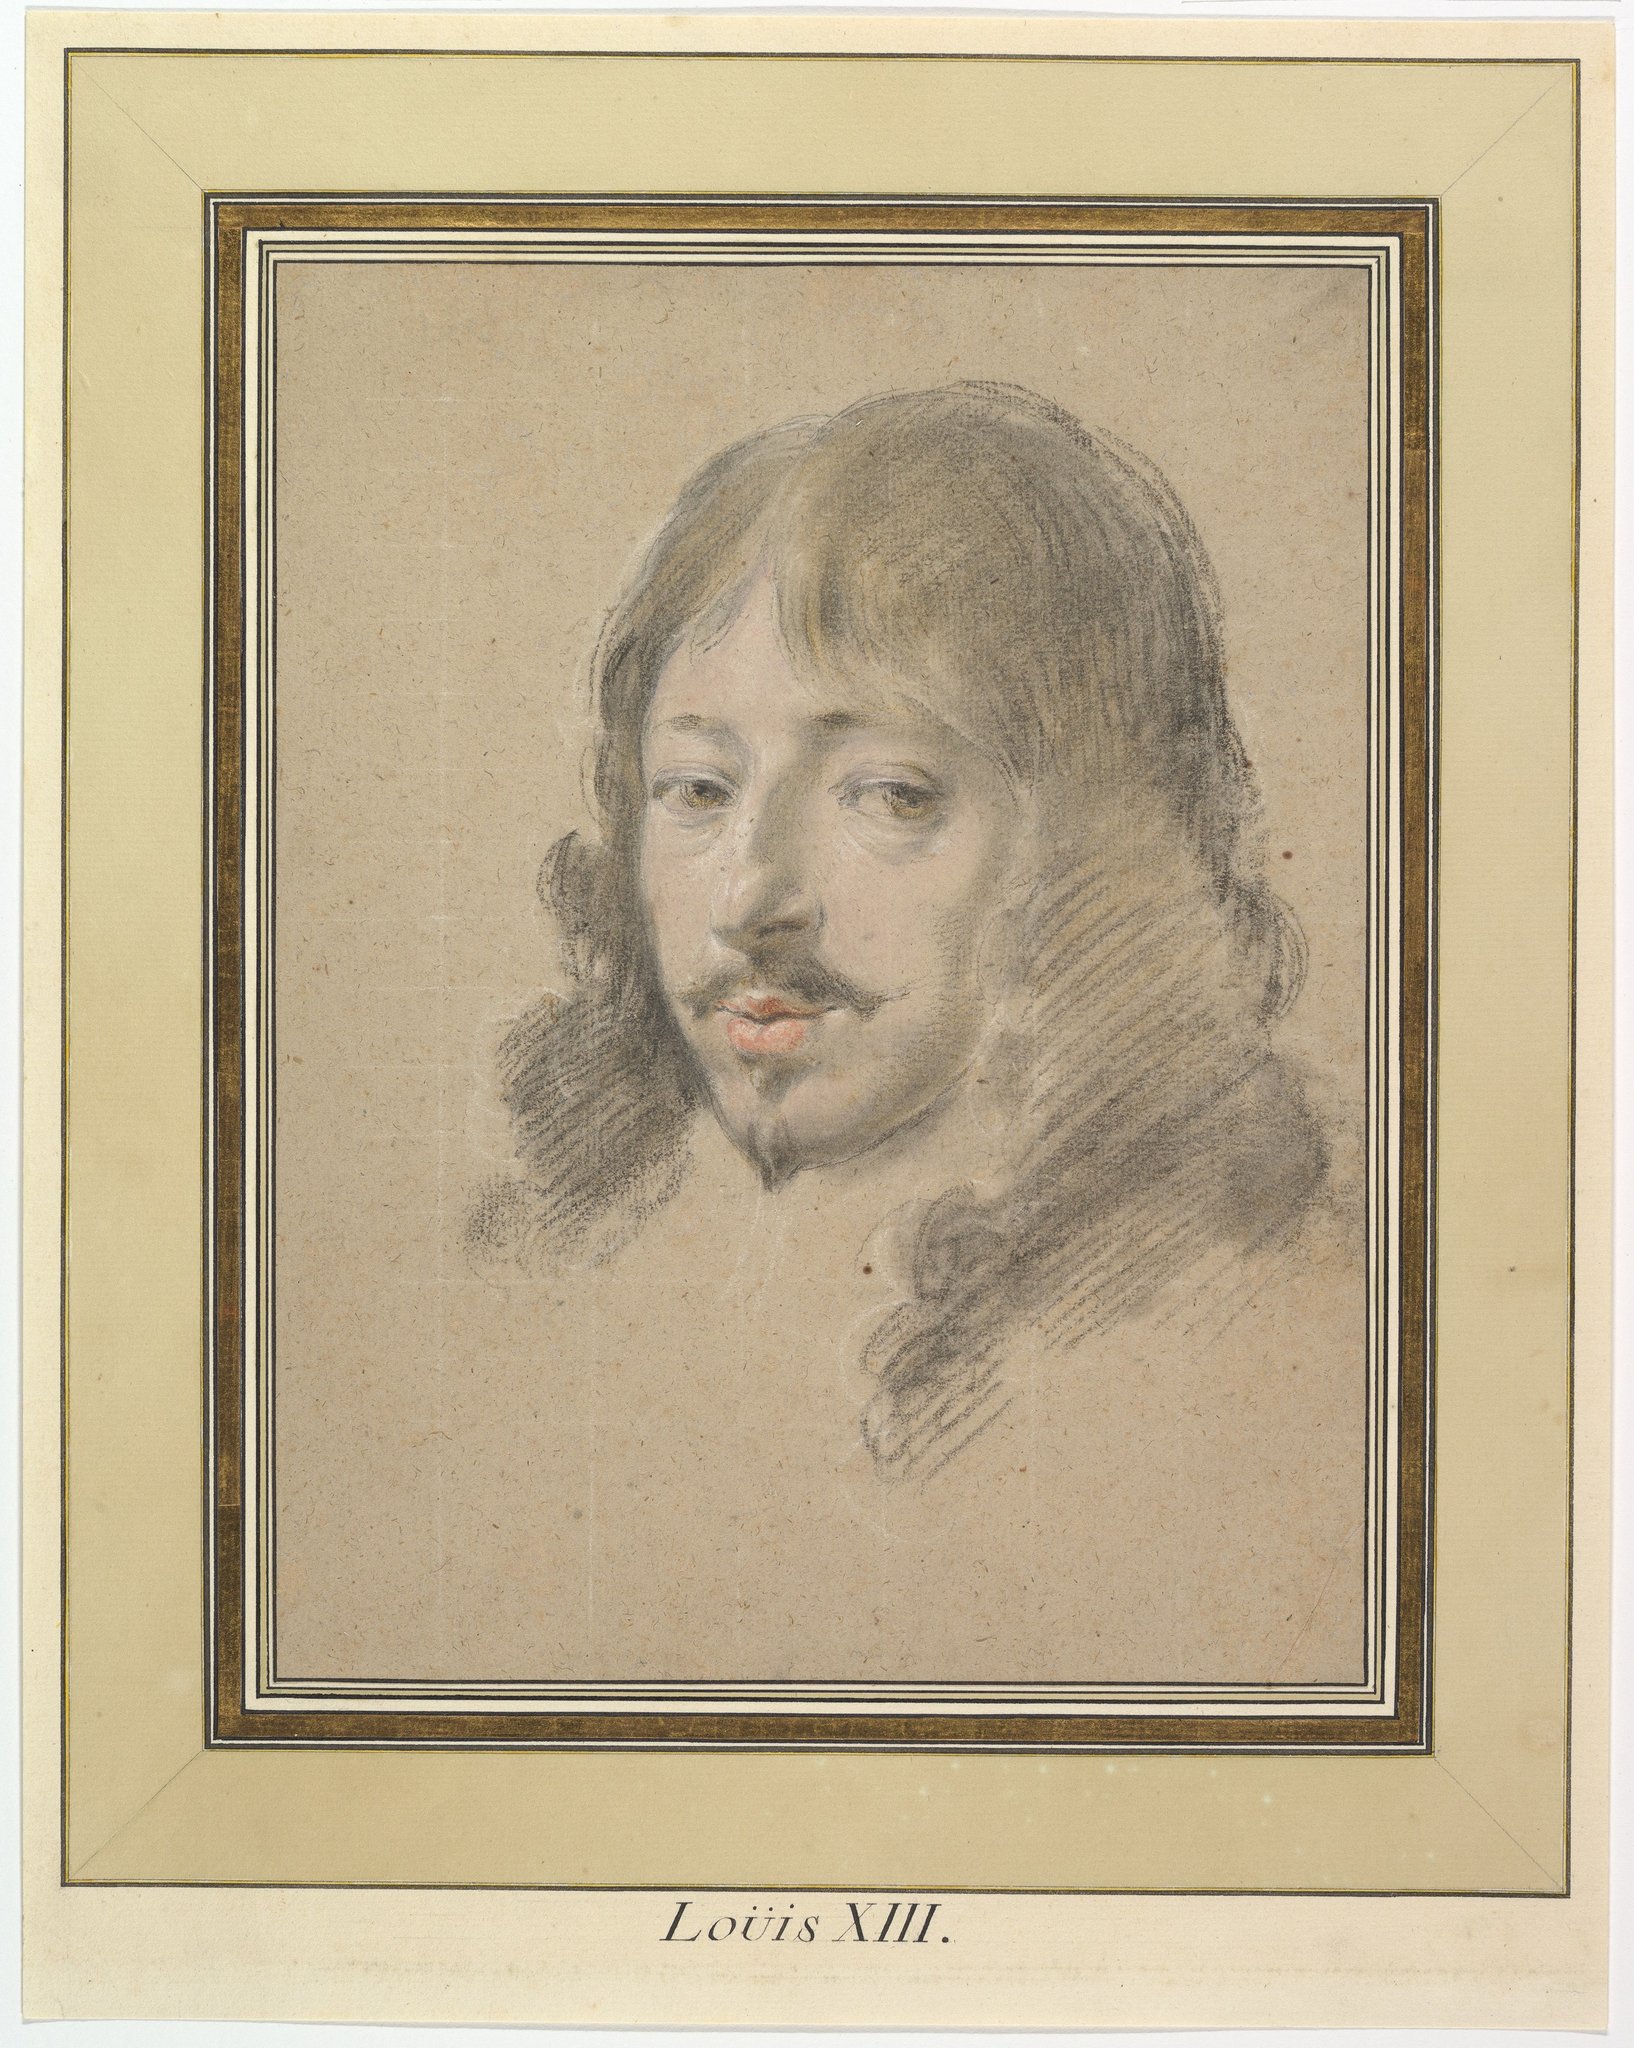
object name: drawing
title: Portrait of Louis XIII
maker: simon vouet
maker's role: artist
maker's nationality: french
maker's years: 1590-1649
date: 1632-1635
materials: chalk, paper, pastel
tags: kings,men,portraits